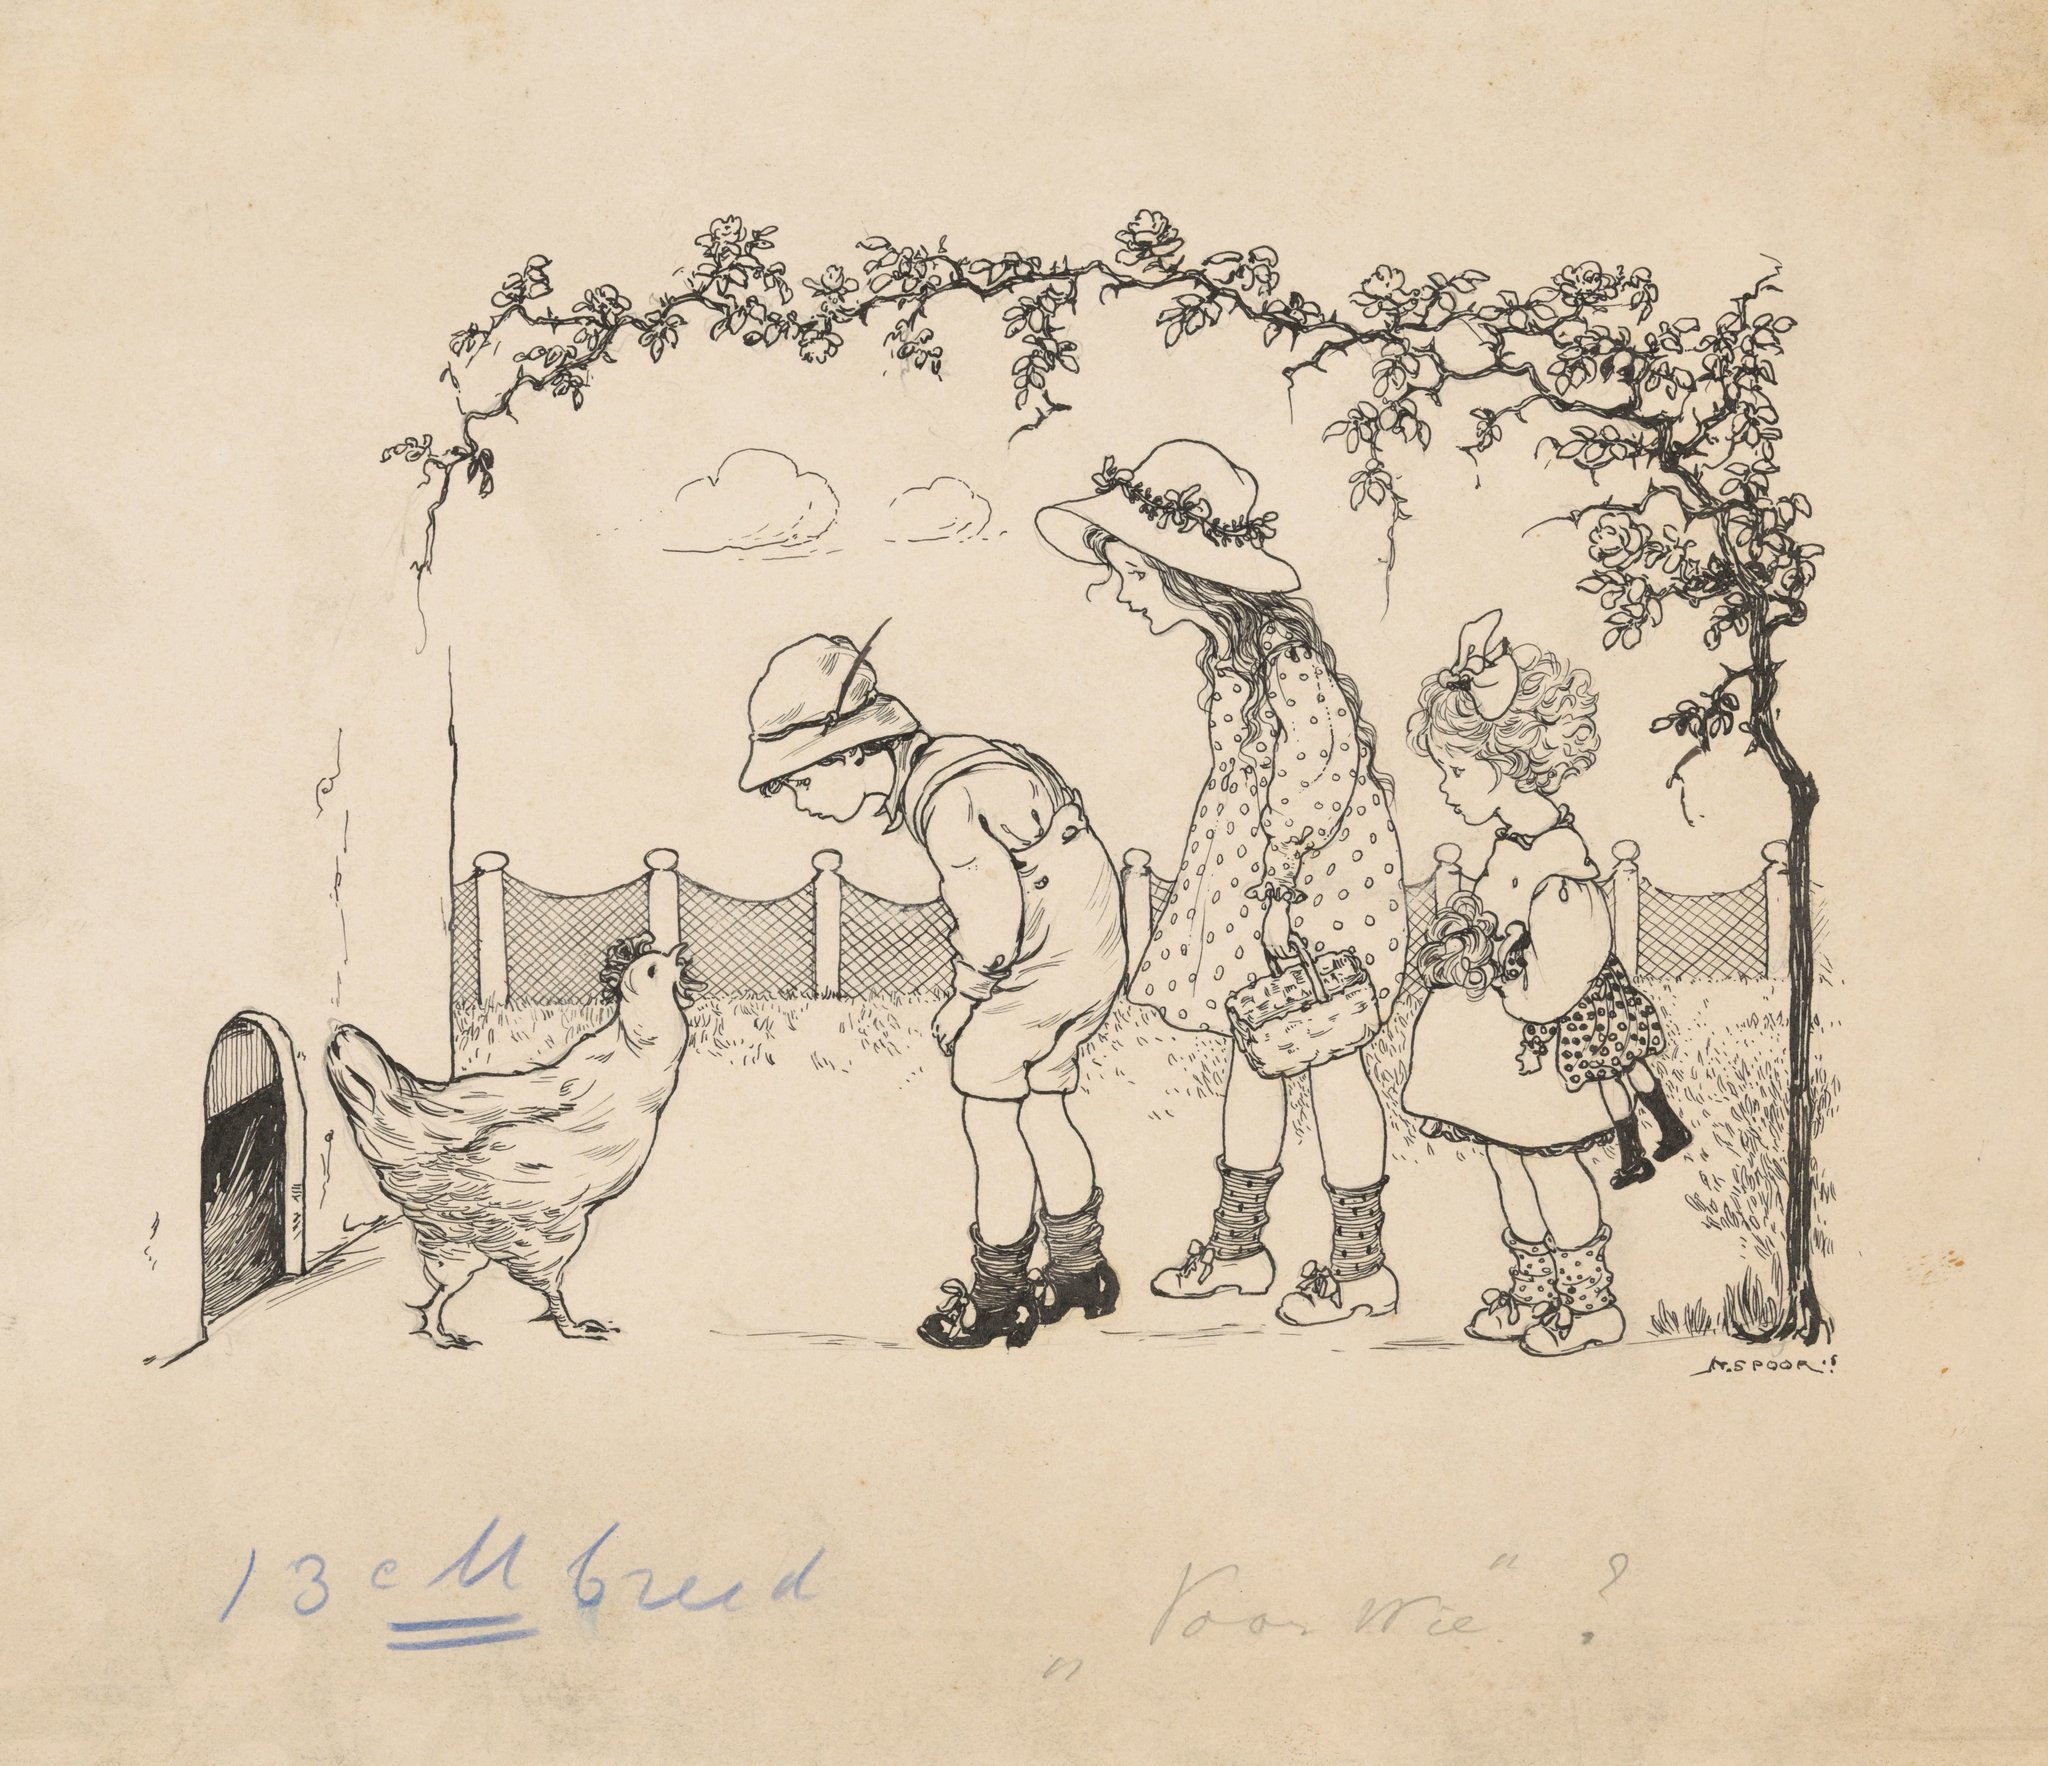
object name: drawing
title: Drie kinderen in een kippenhok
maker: nelly spoor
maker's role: draughtsman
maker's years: 1885-1950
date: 1916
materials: ink, paper, pencil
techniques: pen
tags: child, fowl (cock, hen, chicken, etc.), chicken house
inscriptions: collector's mark: Lugt 2228, :, annotation: ‘" Voor wie" ?’, signature and date: ‘N. SPOOR 16.’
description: Een jongen en twee meisjes staan achter elkaar op een rij in een kippenhok naar een kip te kijken. Boven hun hoofd groeit een struik.